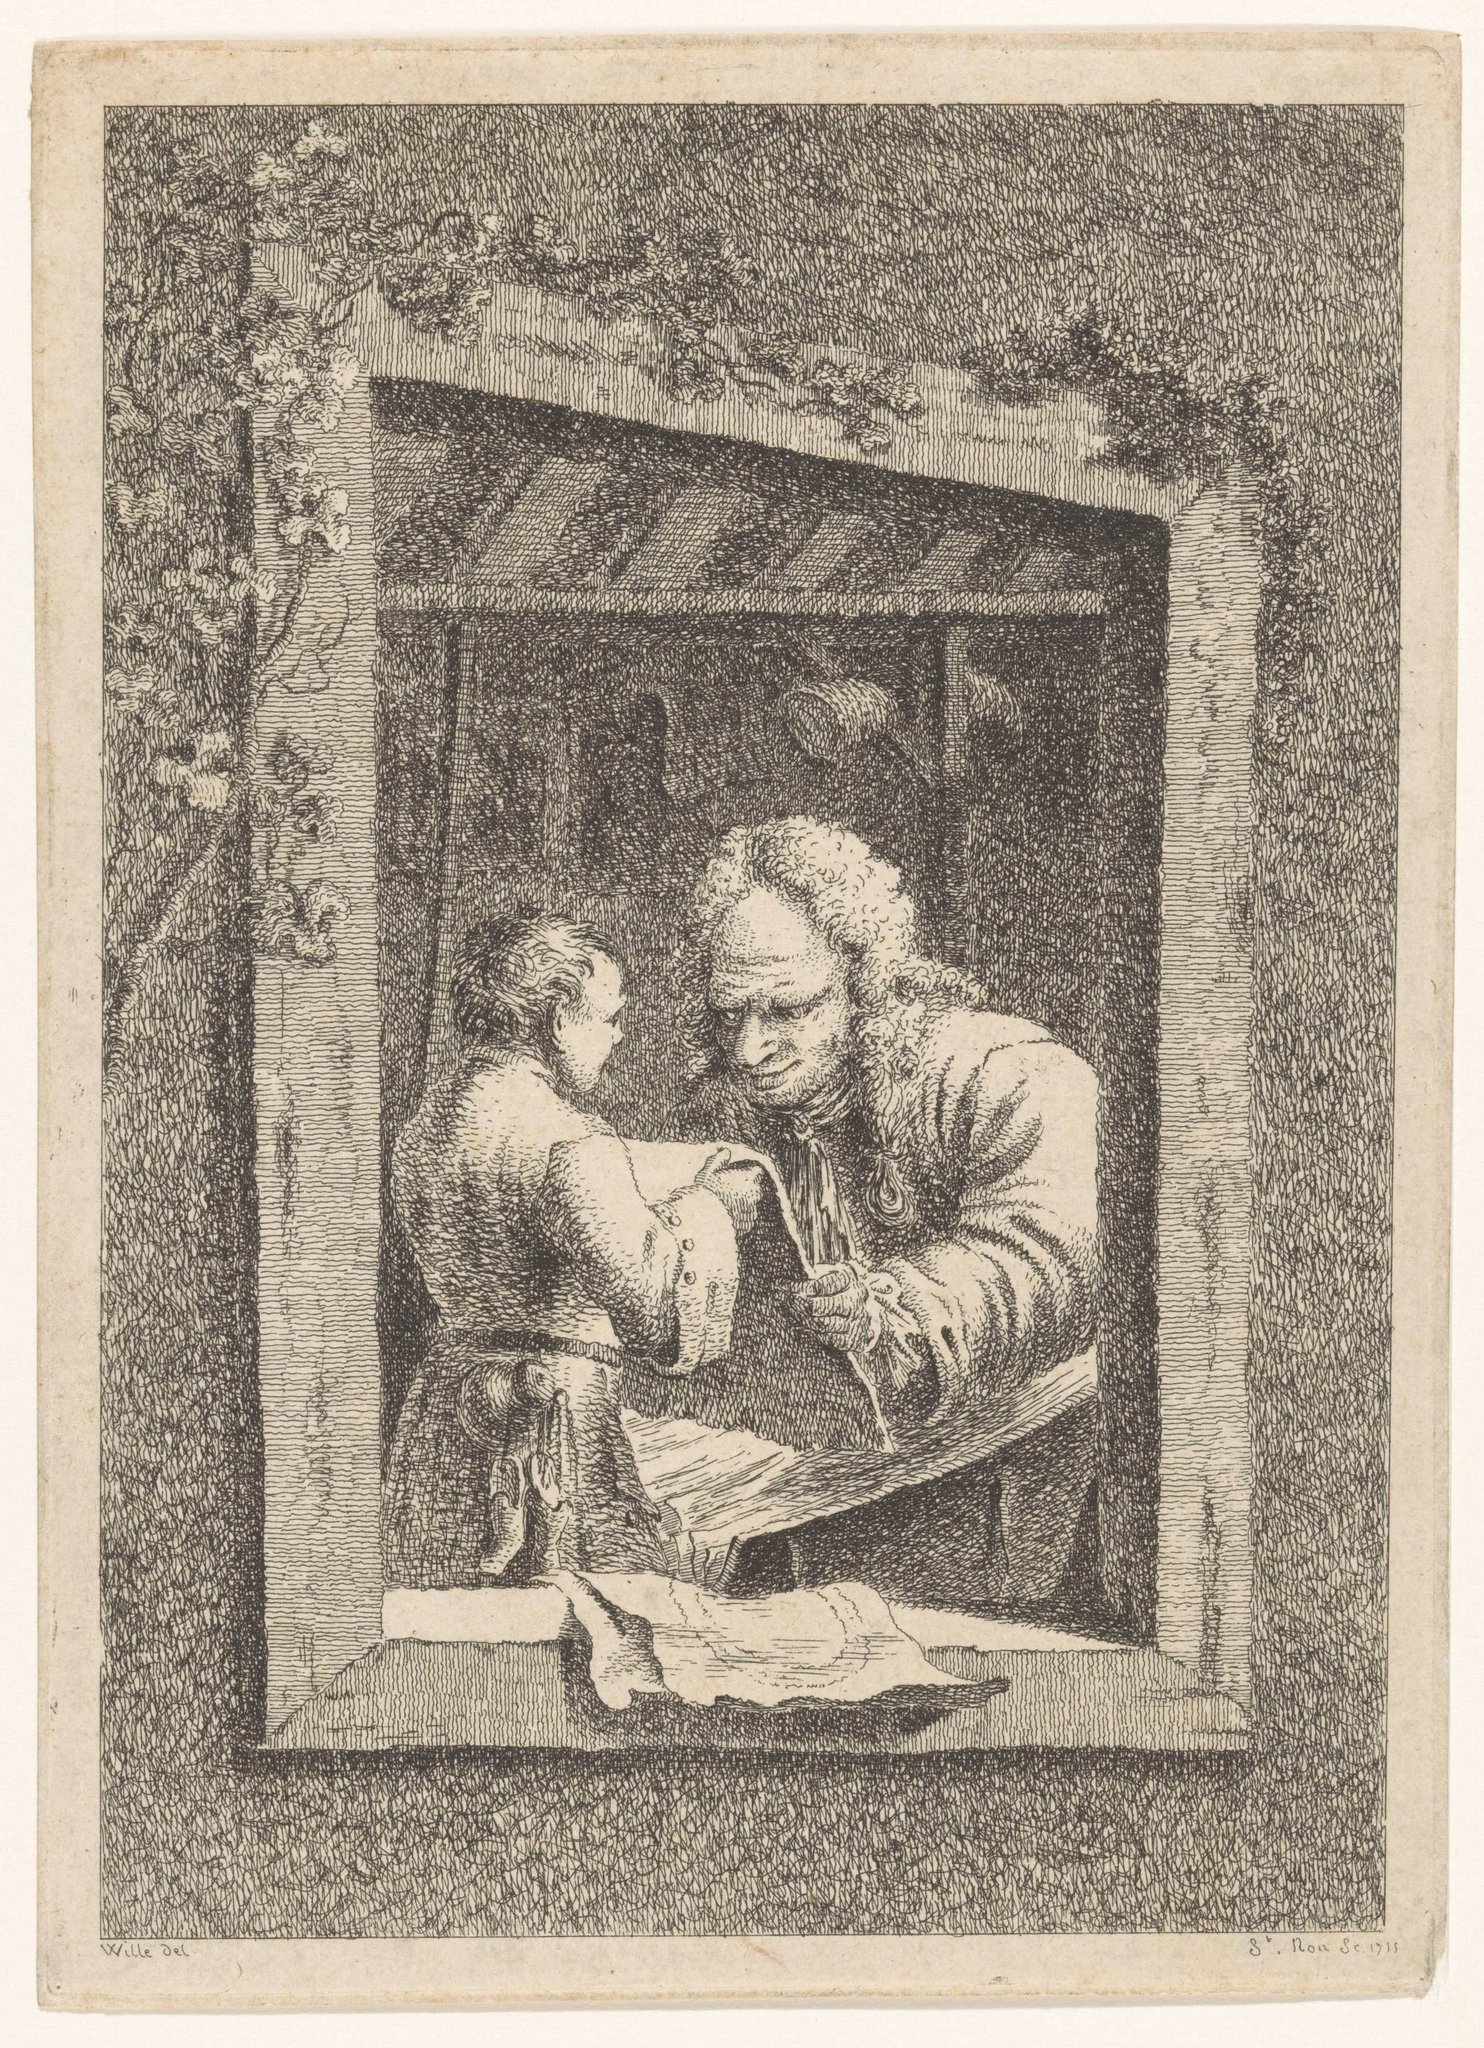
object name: print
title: Prenthandelaar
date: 1755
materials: paper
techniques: etching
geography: paris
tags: merchant, salesman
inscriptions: collector's mark: Lugt 4780, collector's mark: Lugt 2228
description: Doorkijk door een venster. Binnen een jonge prenthandelaar die zijn prenten aan een klant toont.